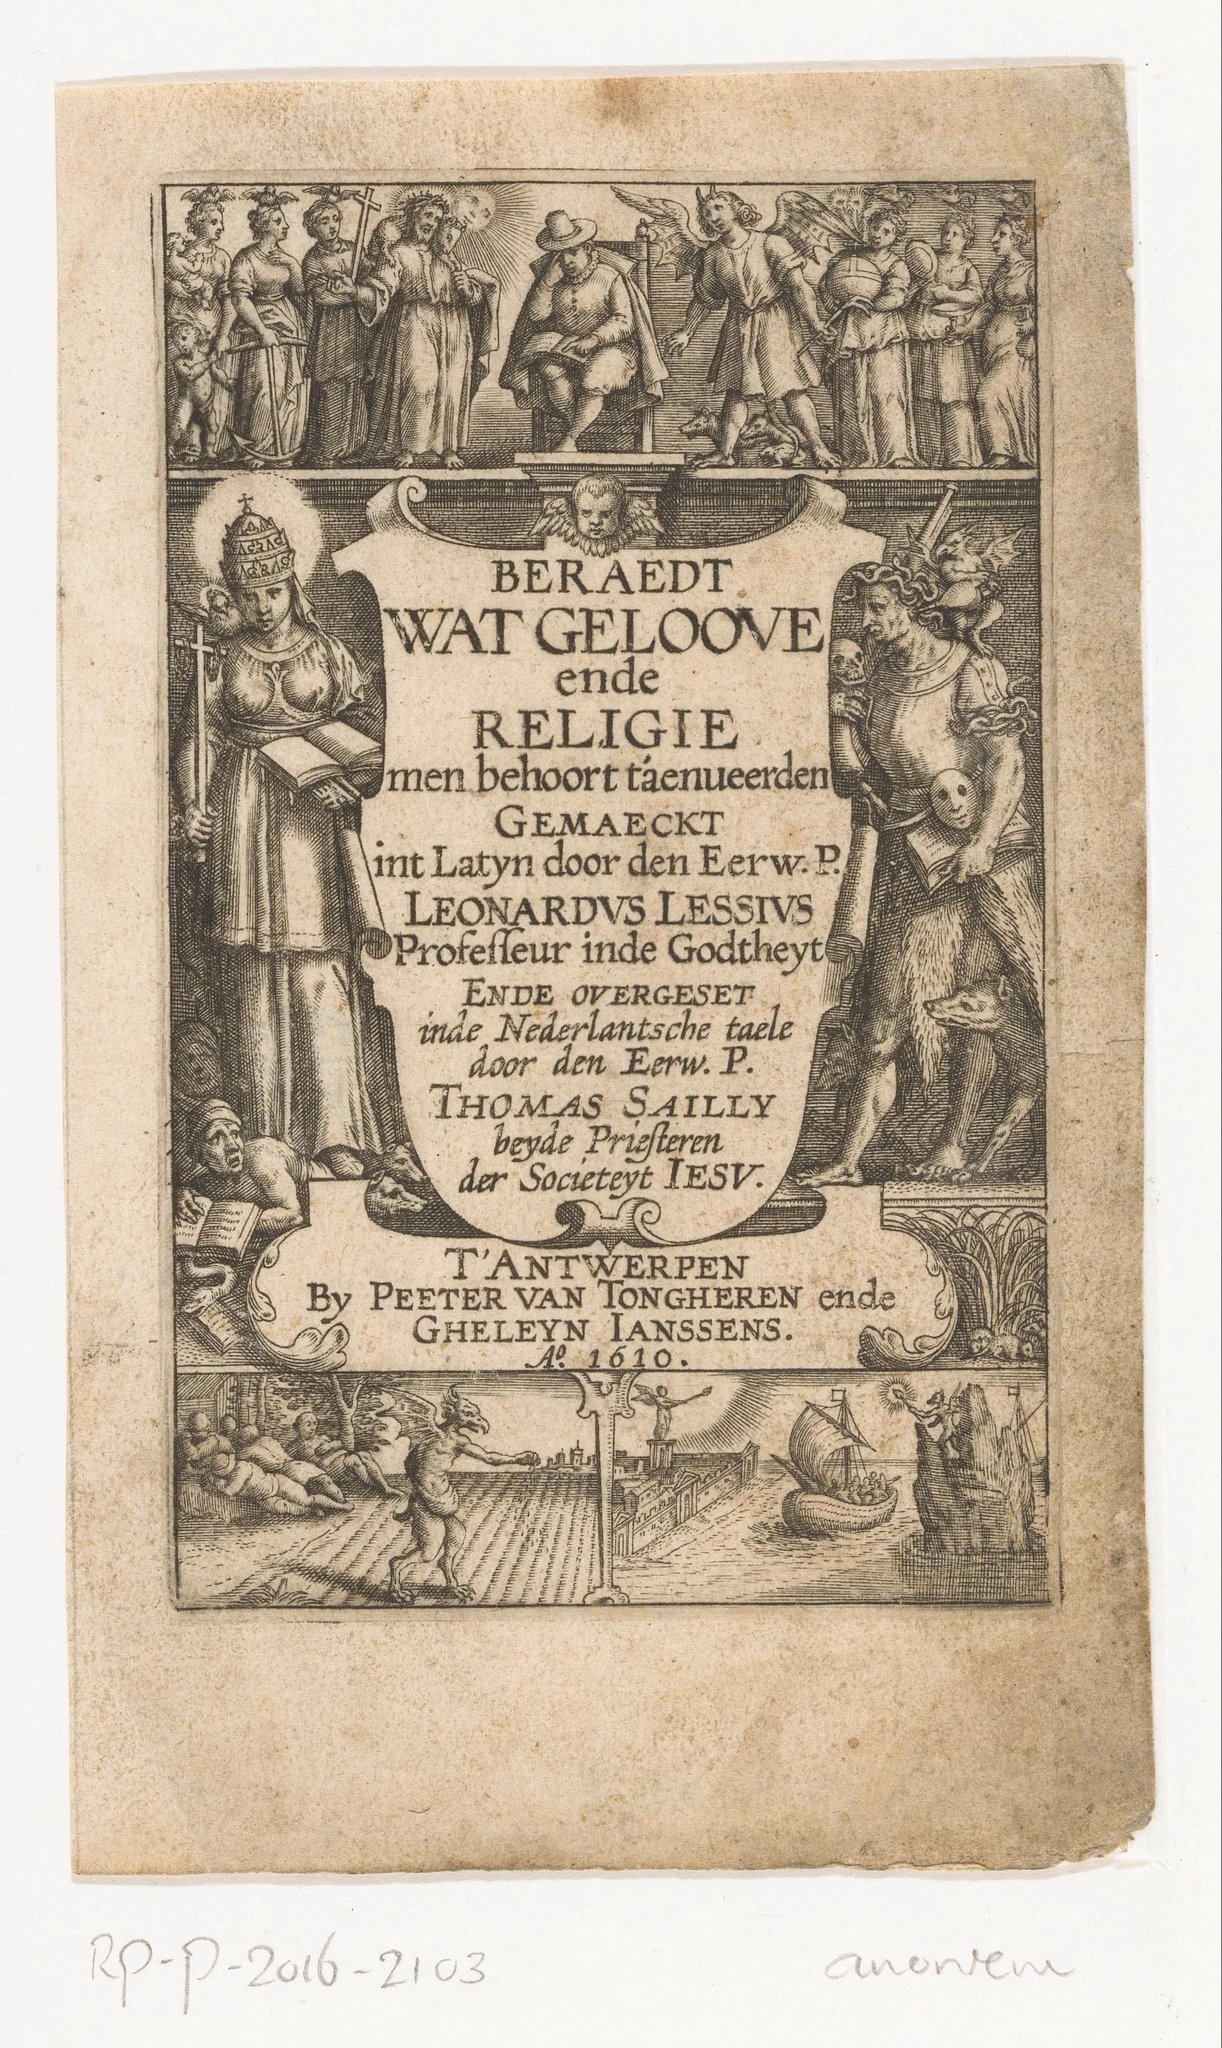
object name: titelblad, titelpagina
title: Allegorie over het Ware Geloof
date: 1610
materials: paper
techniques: engraving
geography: antwerp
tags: true religion vs. false religion, the three theological virtues, devil(s) and demons, vice, and the seven deadly sins, the church or christian religion vs. paganism and unbelief, the (true) church vs. other churches and ideas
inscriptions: collector's mark: Lugt 1379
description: De personificatie van het Katholieke Geloof met pauselijke tiara, bijbel en kruis flankeert samen met een duivelse figuur met slangen, doodskop, masker en honden de boektitel. Aan de bovenzijde zit een man te midden van Christus en de goddelijke deugden en de duivel en de ondeugden. Aan de onderzijde links een scène van een zaaiende duivel en een schip dat vaart tussen een hemels en een hels gebied.